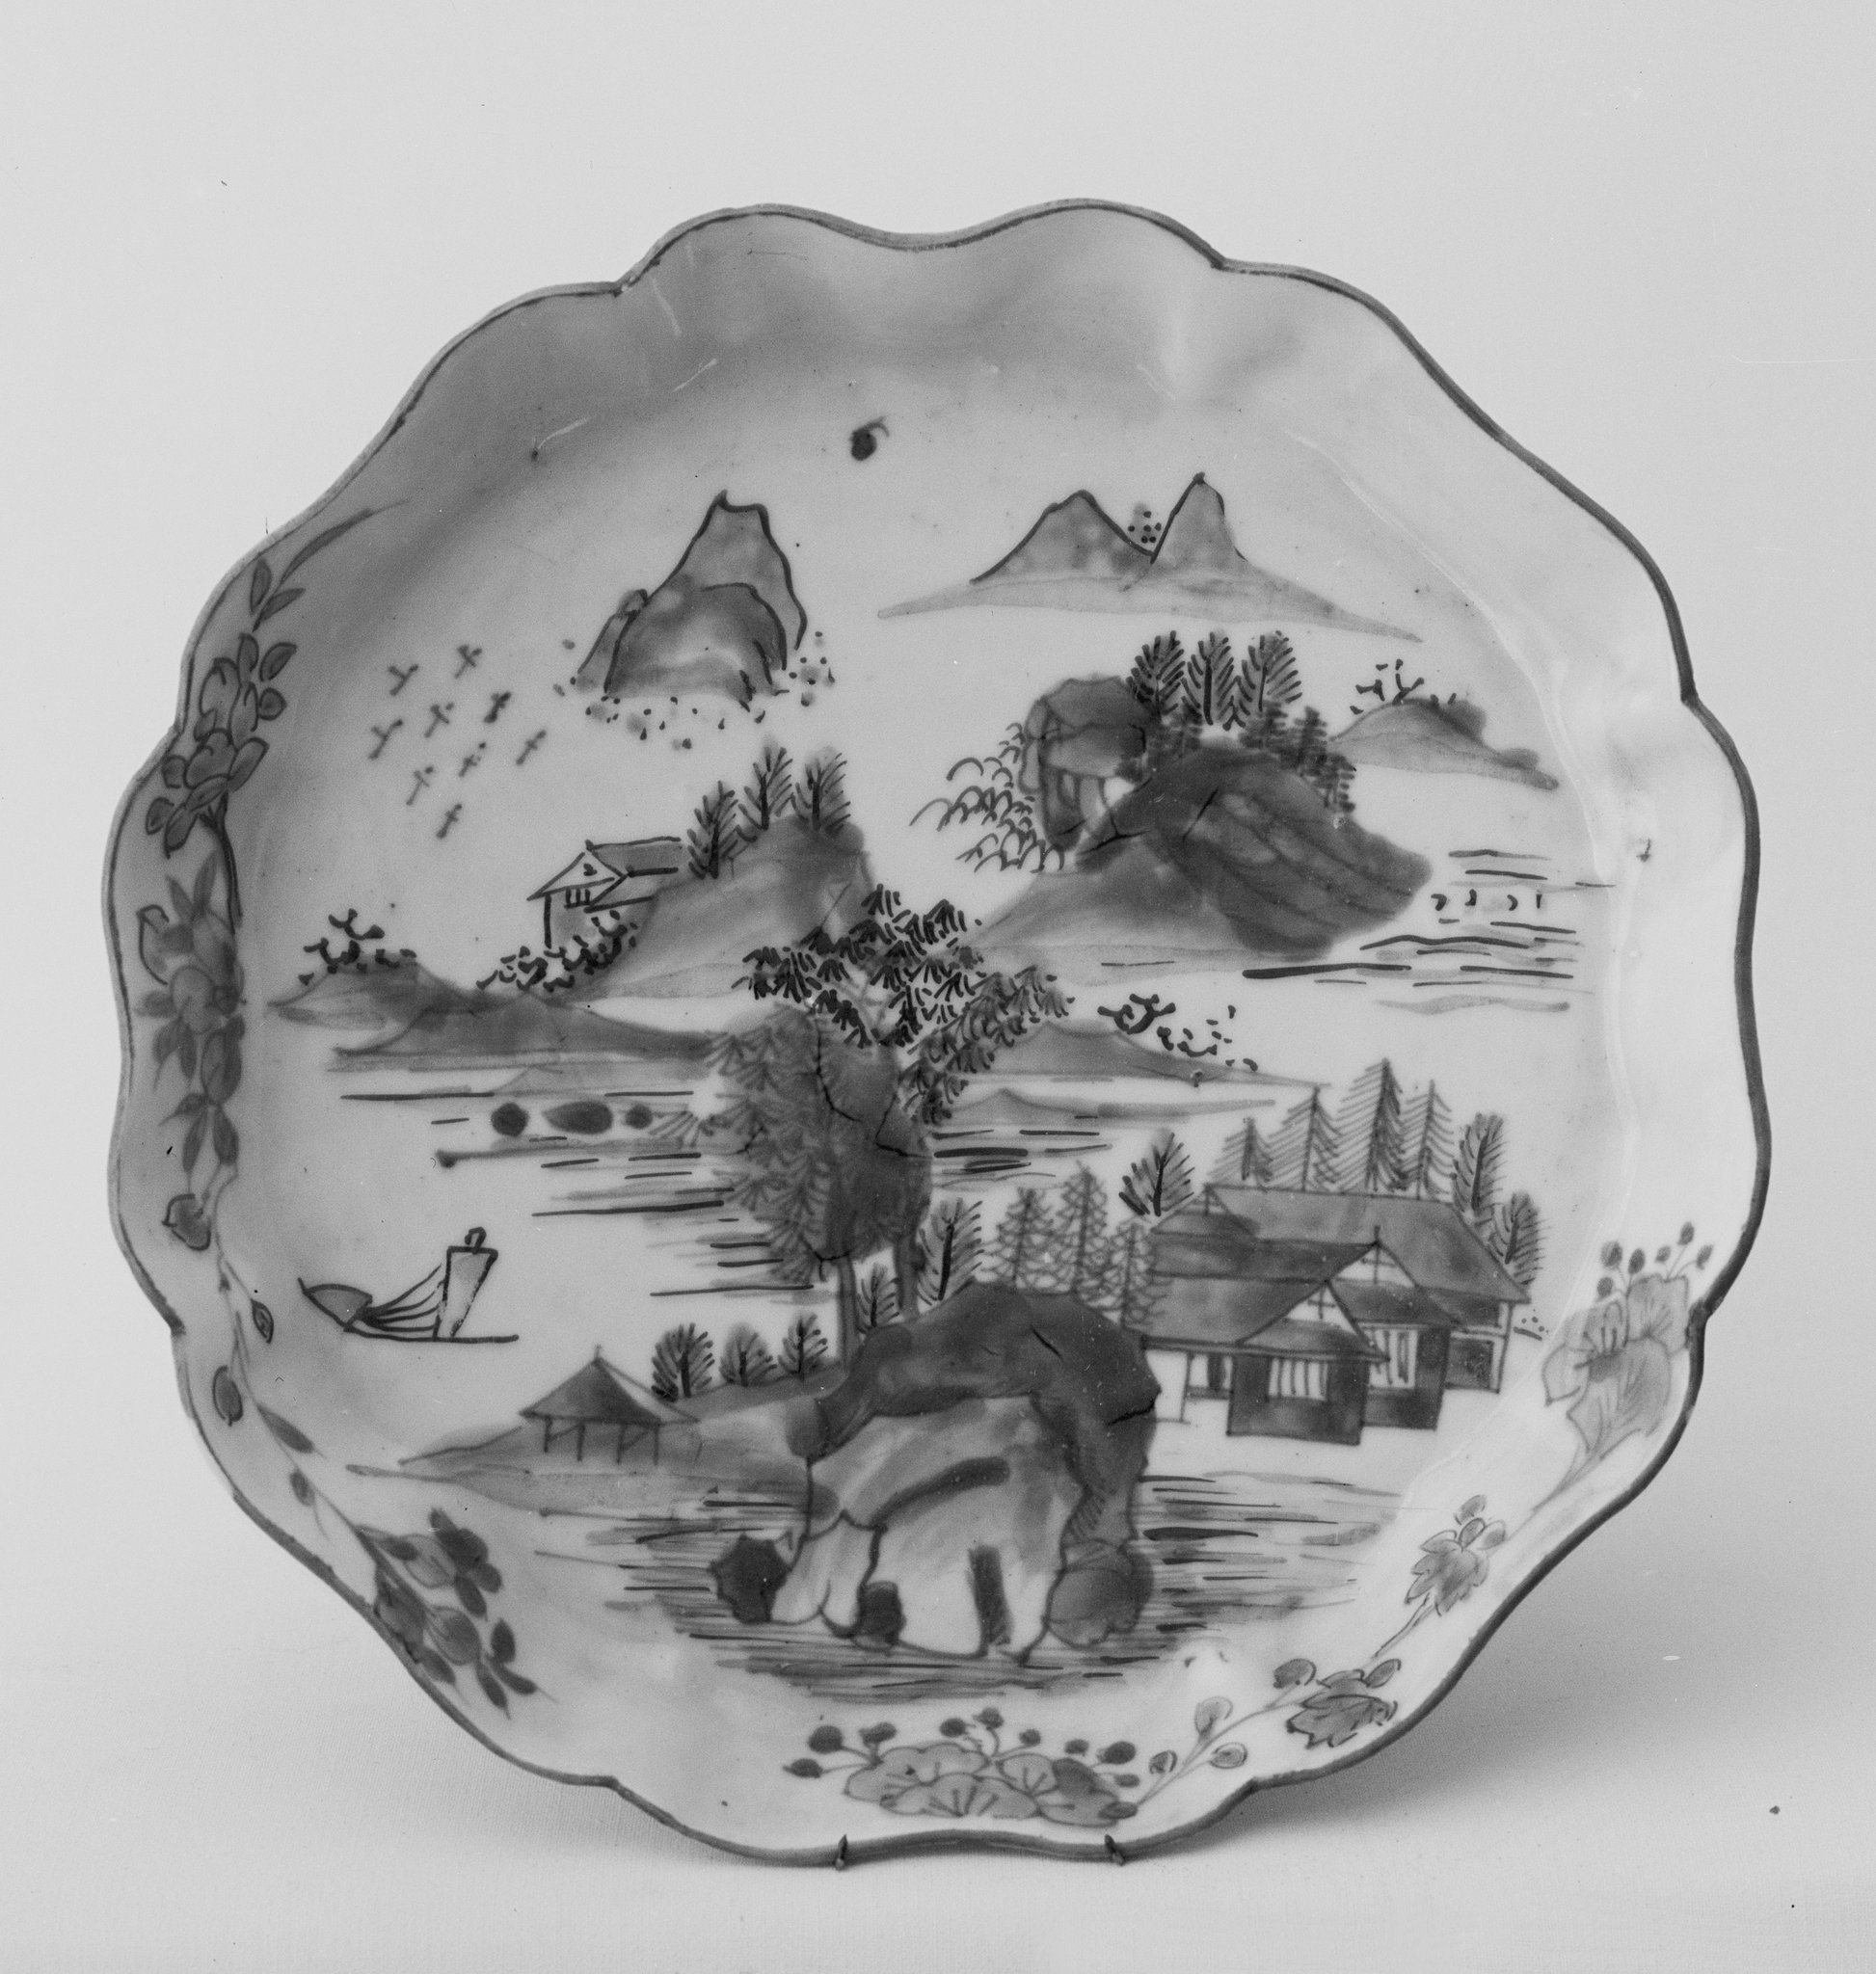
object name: dish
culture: chinese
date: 1626-1650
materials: enamel, porcelain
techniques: overglaze, painting, polychrome, underglaze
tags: houses,mountains,trees,boats